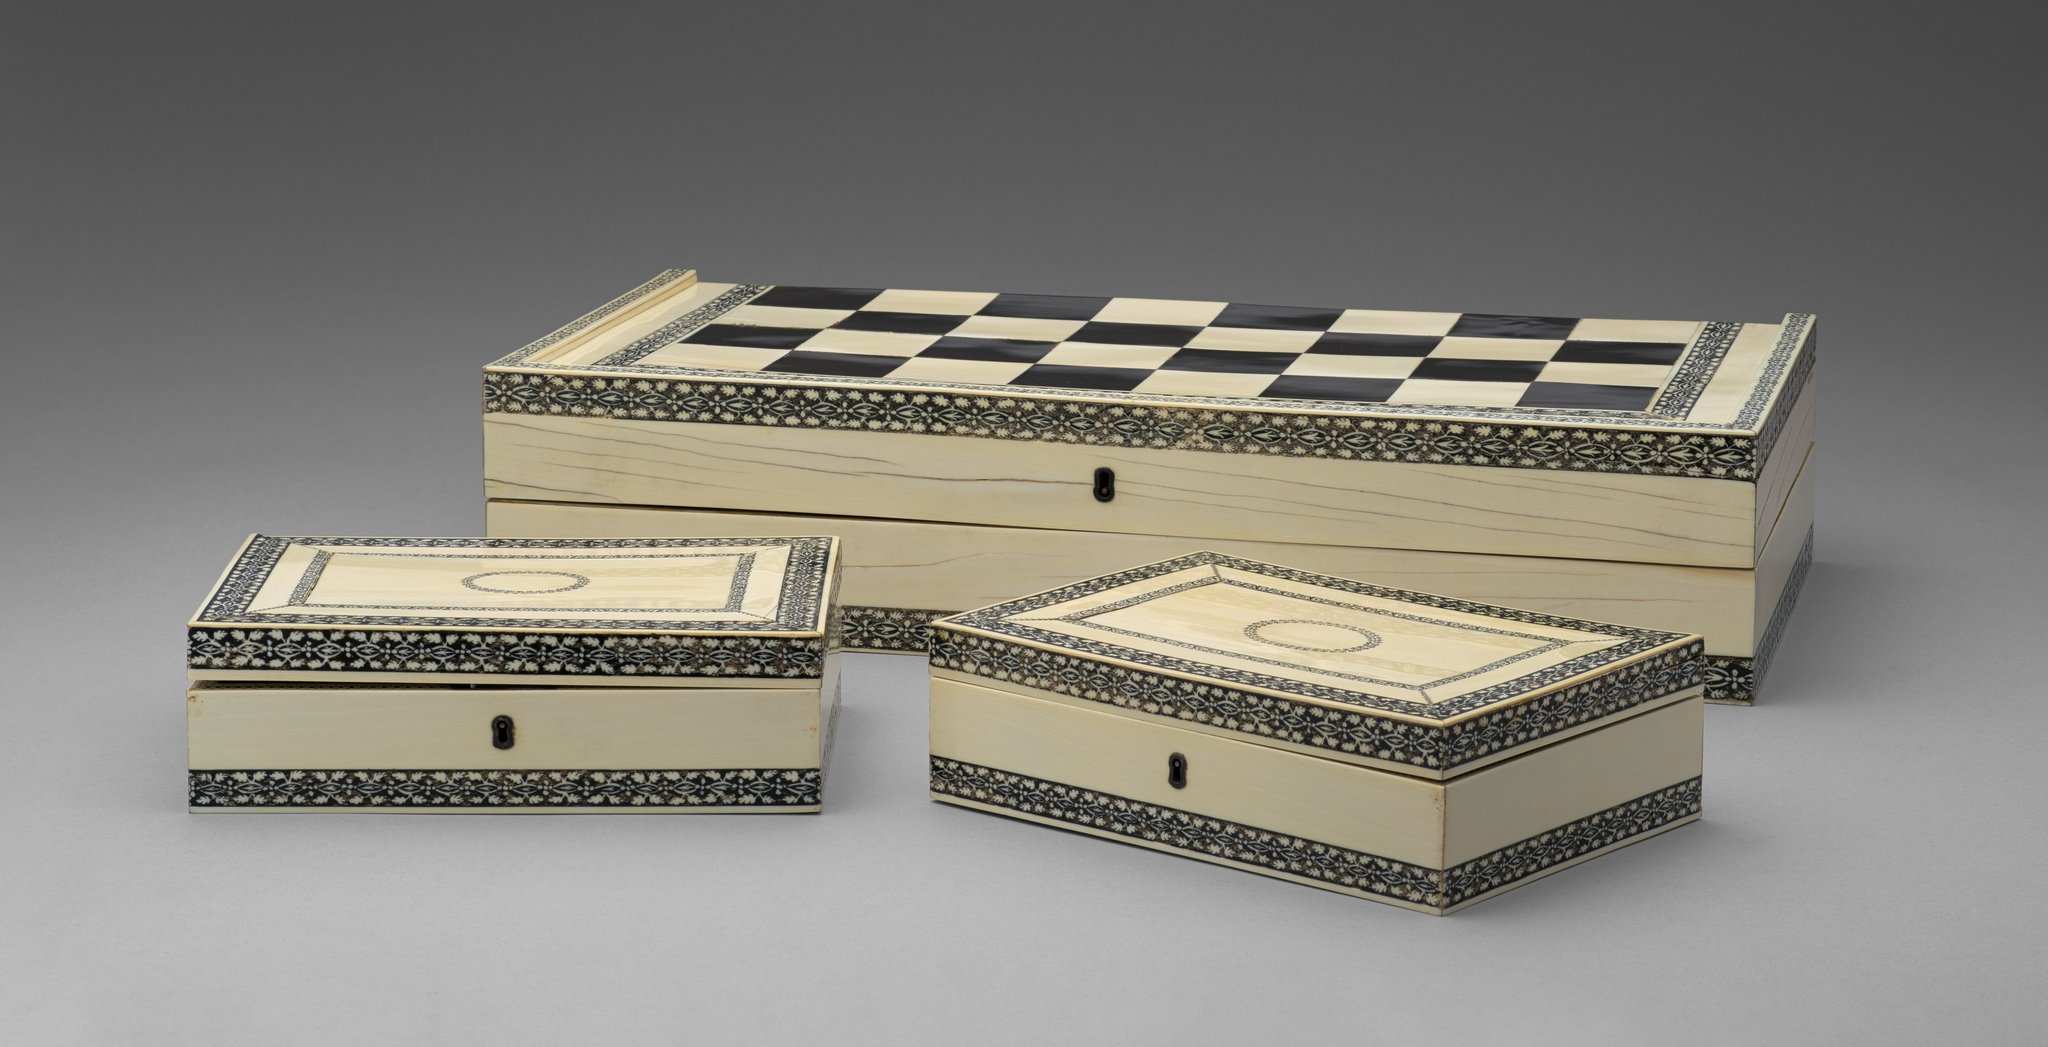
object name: box board and box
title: Box-board for chess and backgammon and boxes (2)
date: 1801-1900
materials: horn, ivory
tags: chess